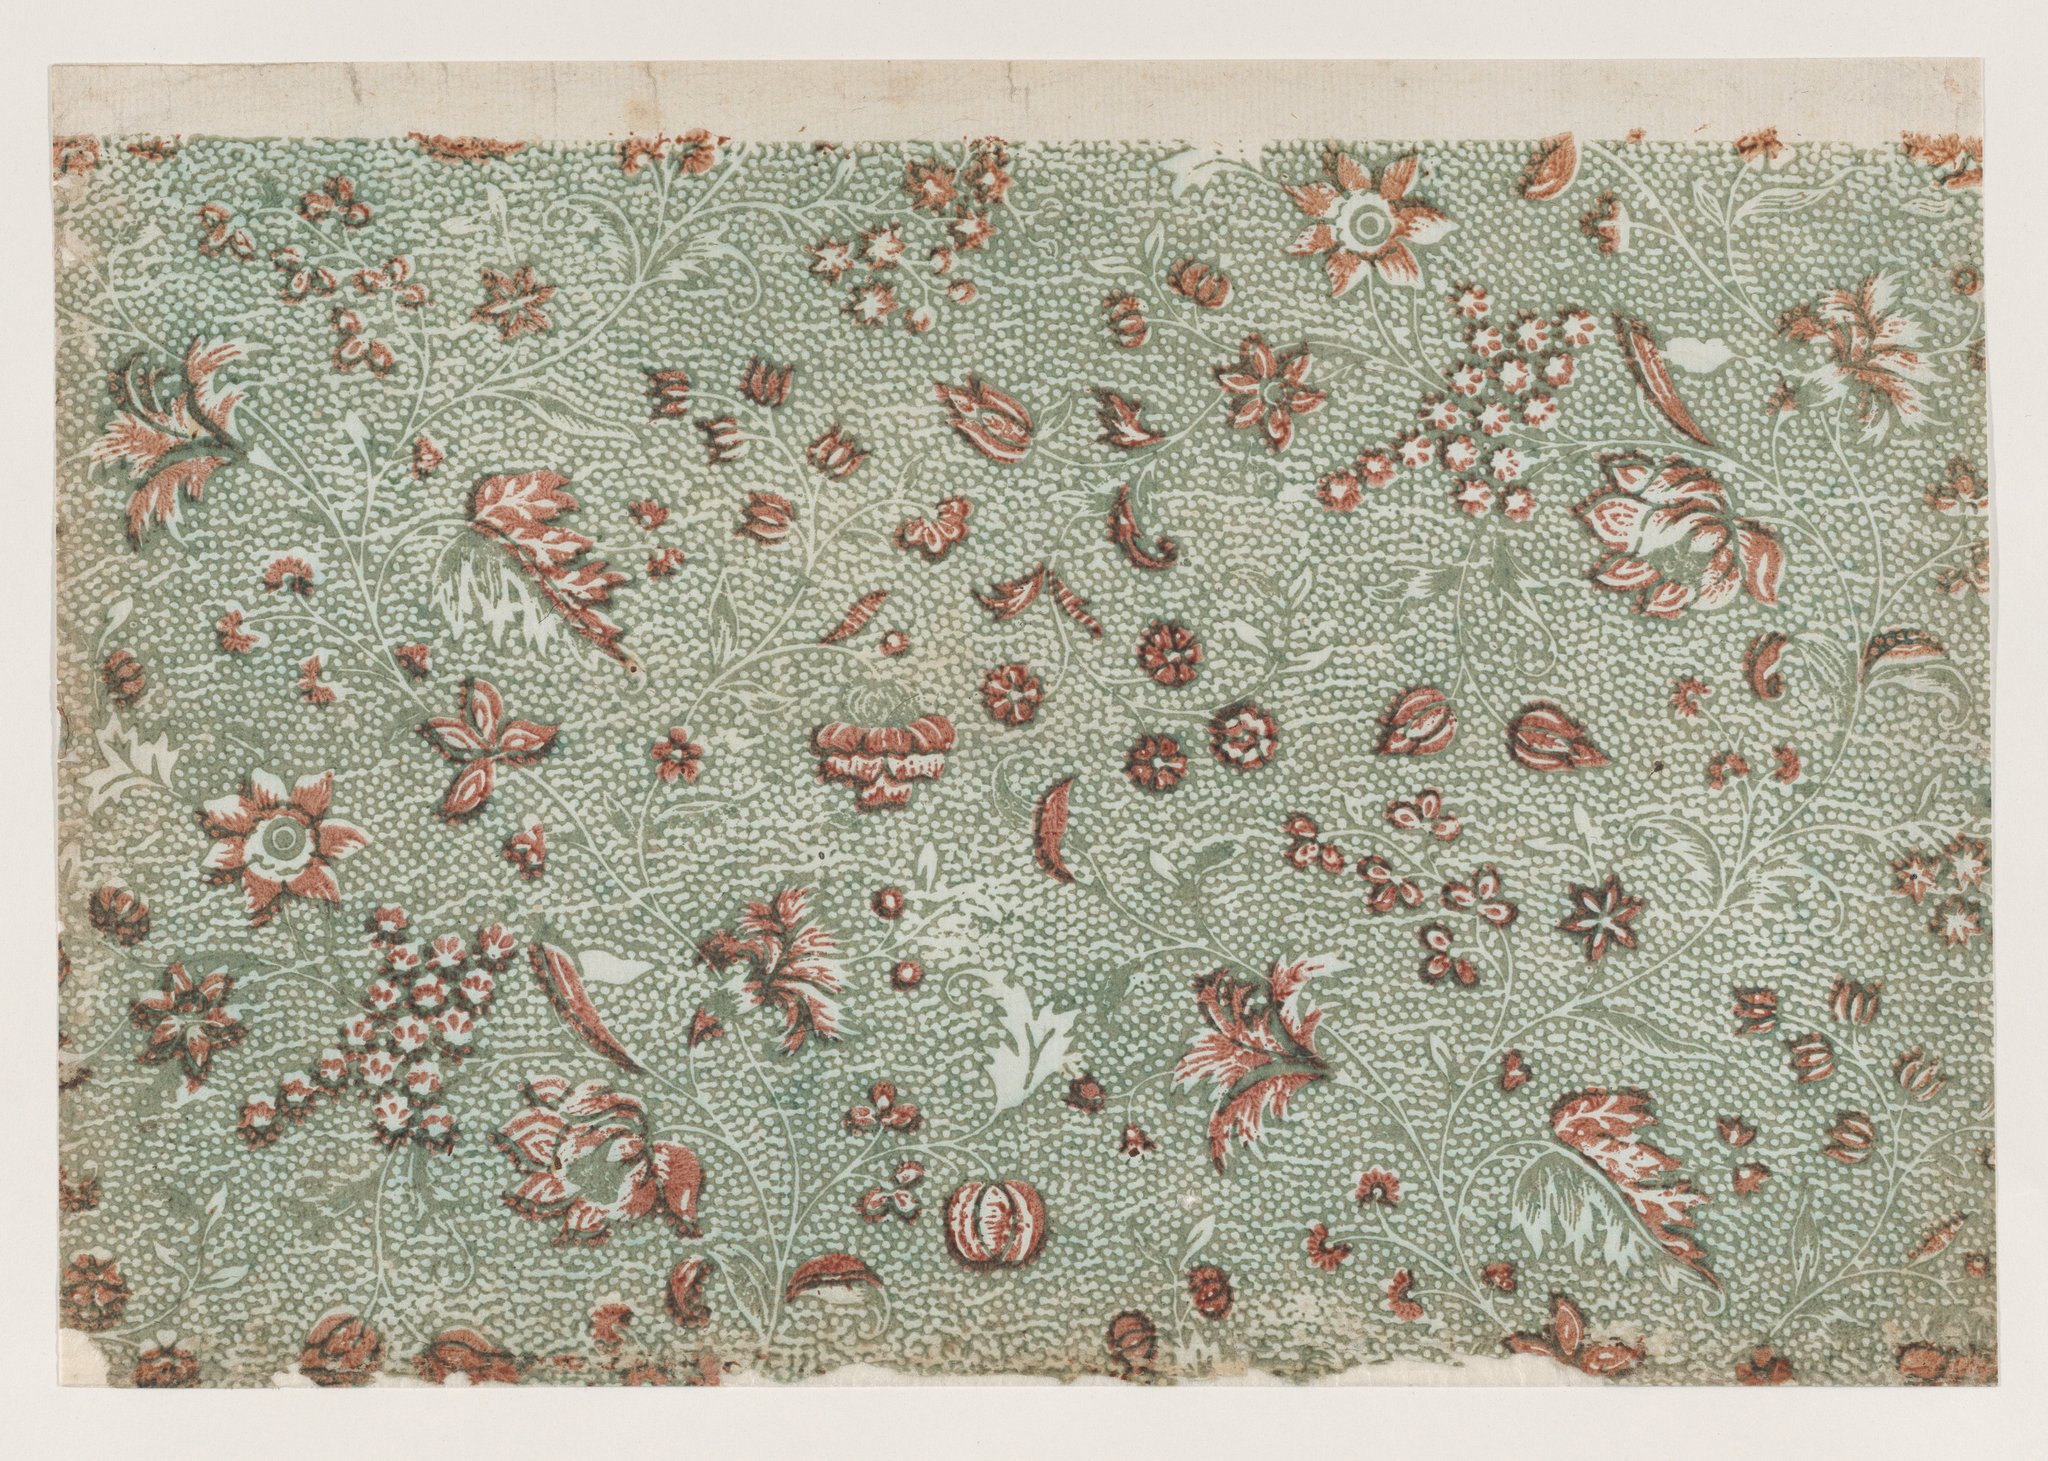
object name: print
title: Sheet with overall floral and vine pattern with dots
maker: Anonymous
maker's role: artist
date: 1801-1900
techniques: relief print